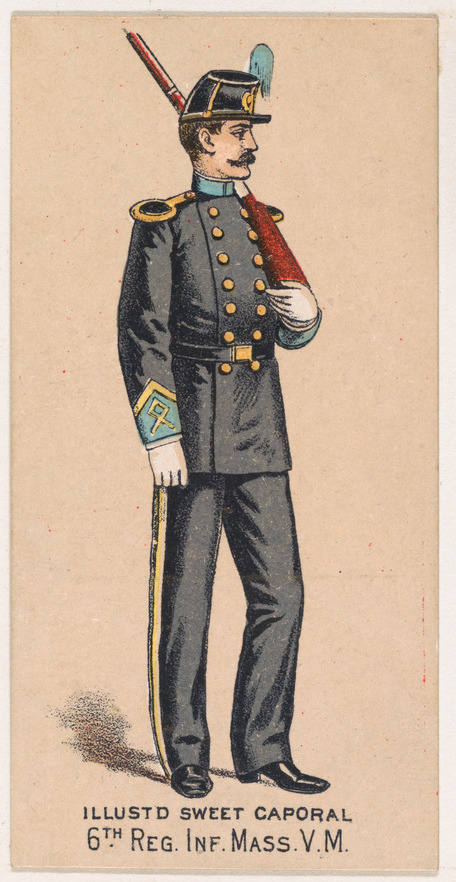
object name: print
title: 6th Regiment, Inf. Massachusetts, V.M., from the Military Series (N224) issued by Kinney Tobacco Company to promote Sweet Caporal Cigarettes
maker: kinney brothers tobacco company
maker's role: publisher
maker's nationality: american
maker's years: 1869-2011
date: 1888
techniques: color lithograph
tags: military,men,profiles